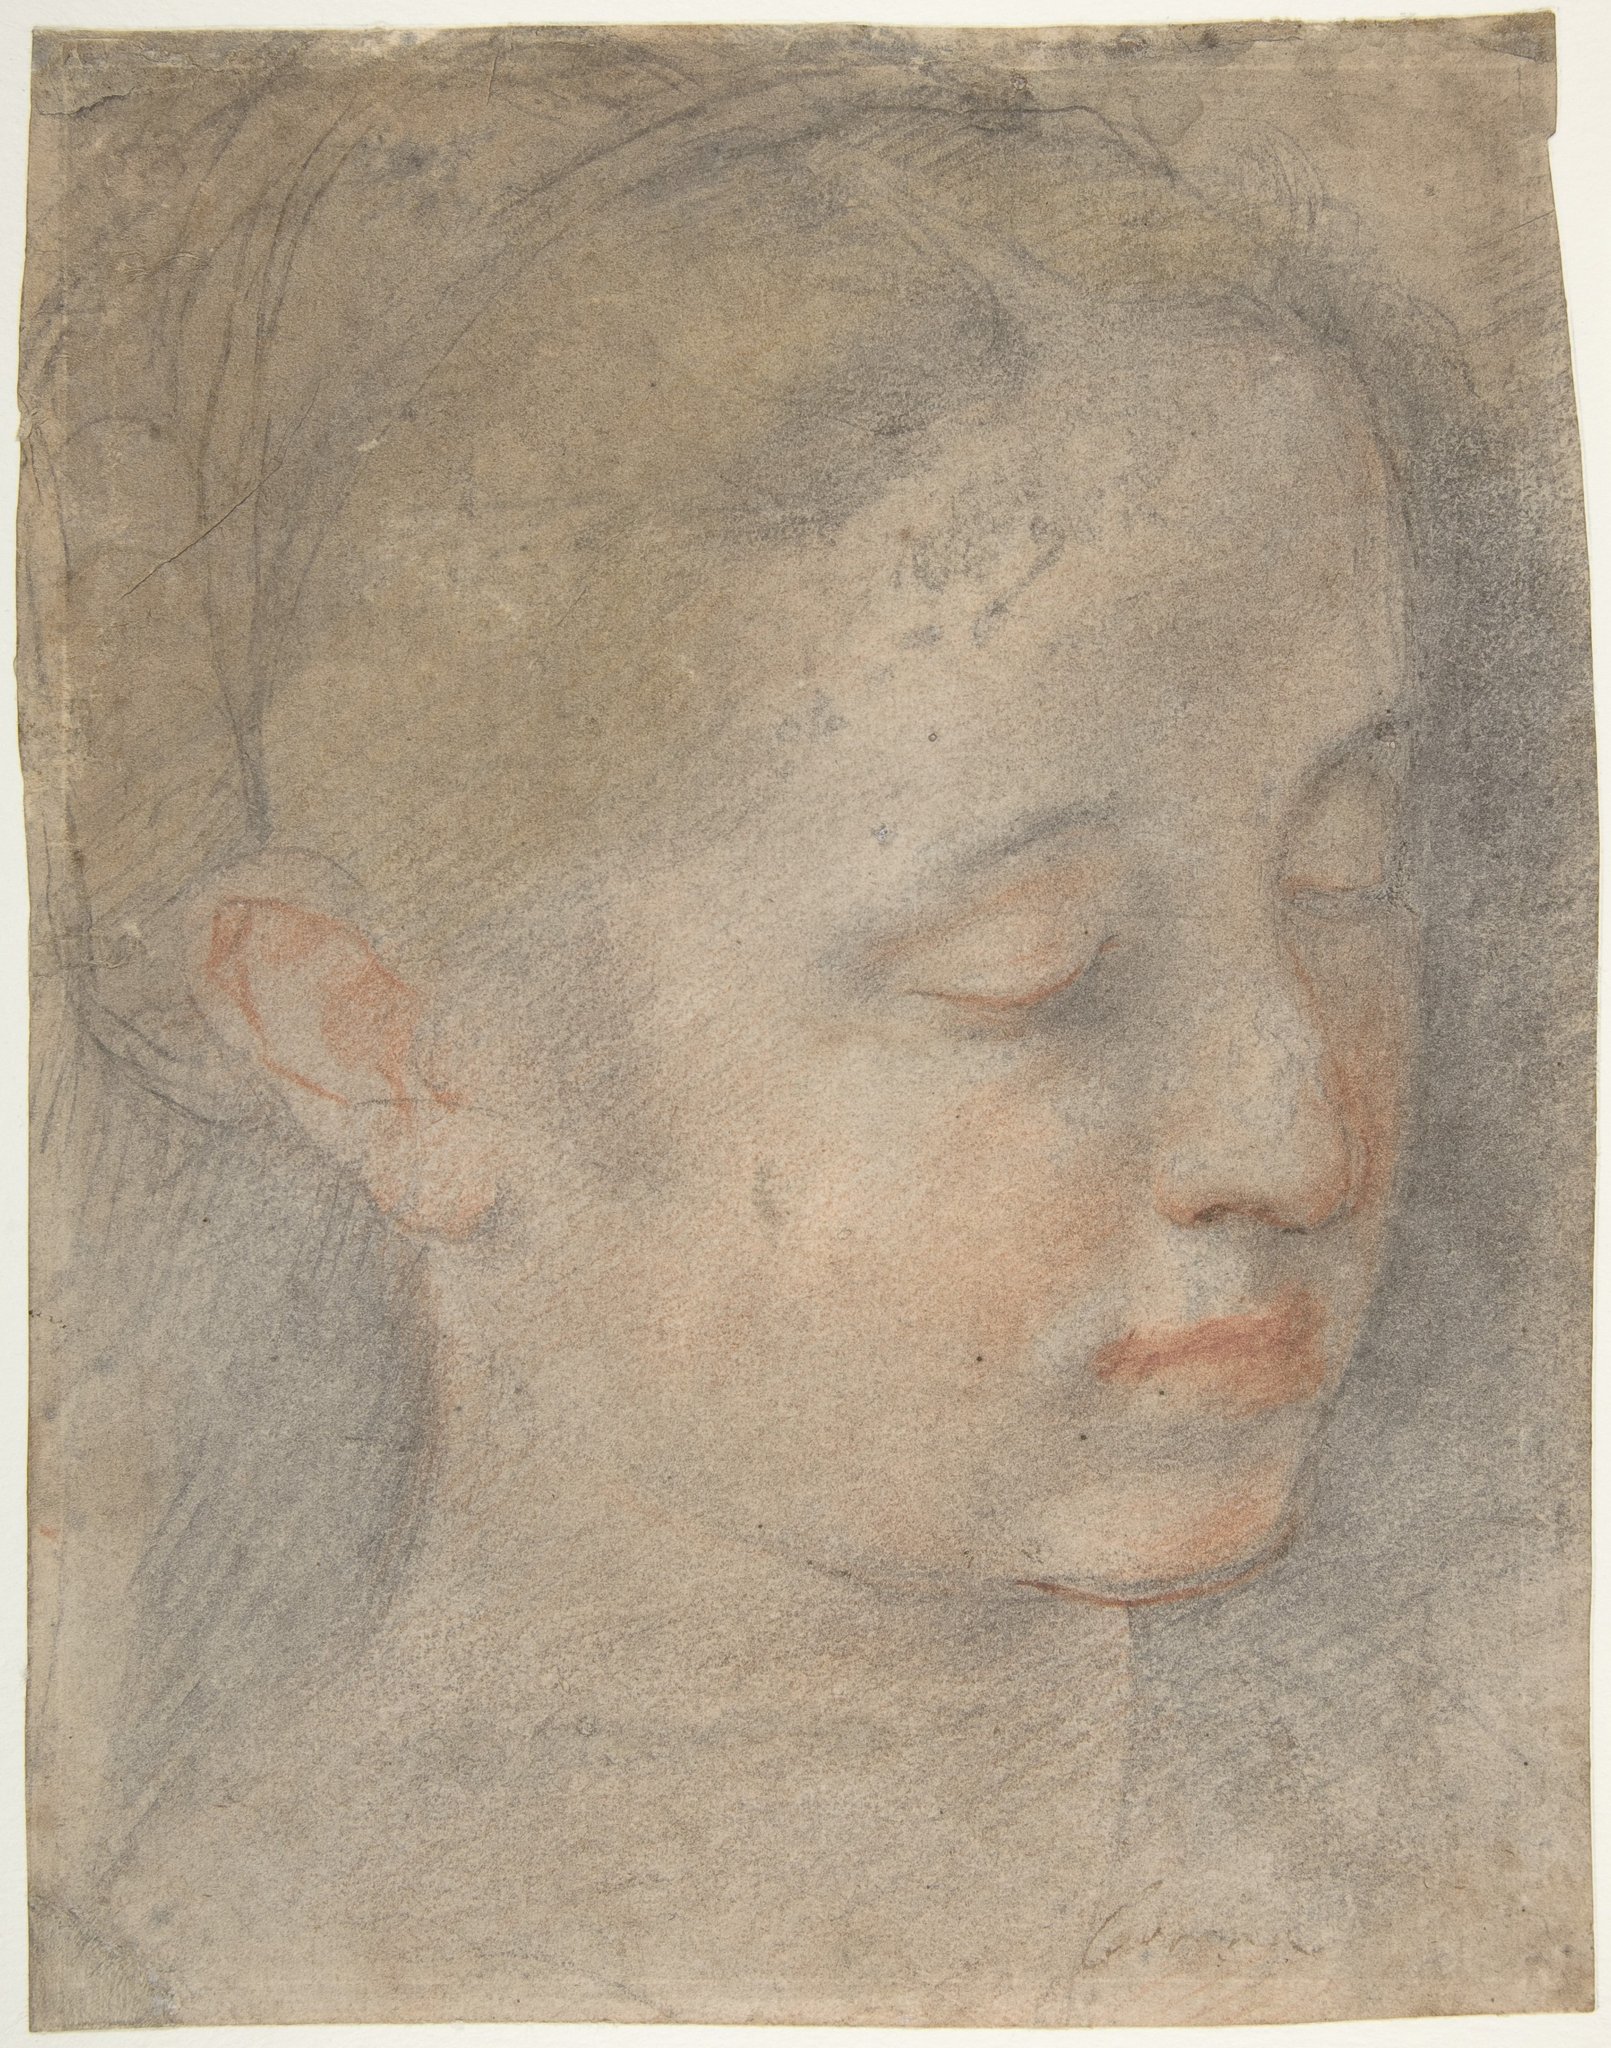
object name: drawing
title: Head of a Young Woman Looking to Lower Right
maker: federico barocci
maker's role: artist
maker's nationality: italian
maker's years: 1535-1612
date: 1565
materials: chalk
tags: heads,women